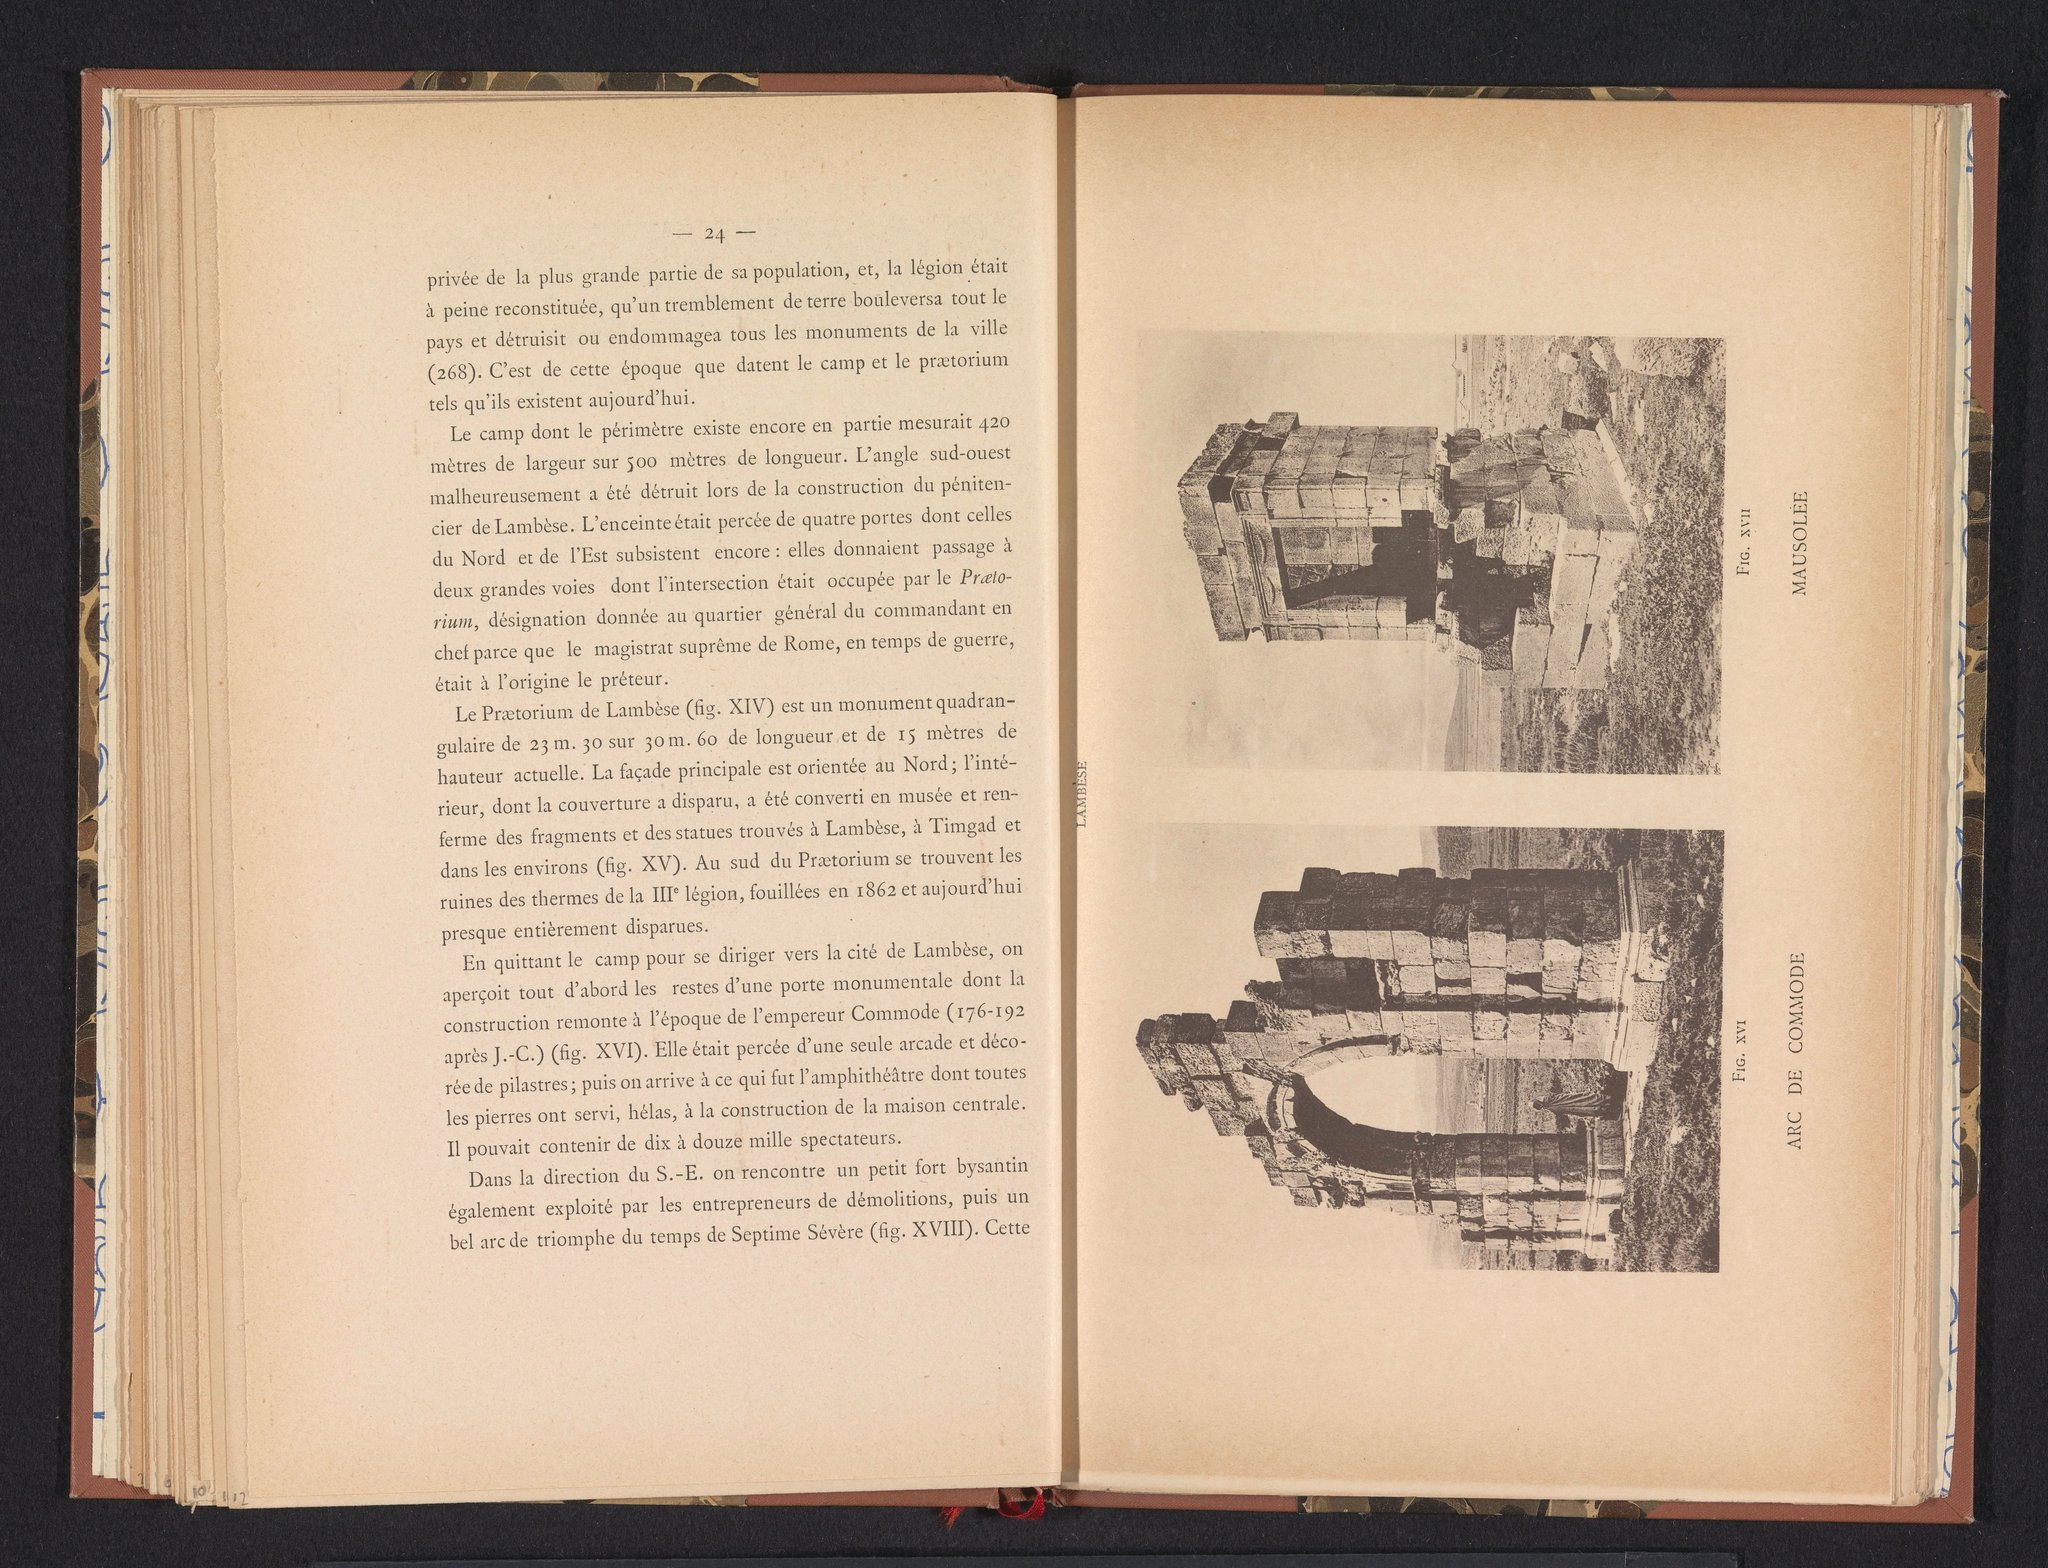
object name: page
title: Romeinse boog en een mausoleum bij Lambaesis in Algerije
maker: Anonymous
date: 1884-1894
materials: paper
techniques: photograph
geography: france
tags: mausoleum, gate, entrance, ruin of a dwelling, house, castle, etc.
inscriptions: number: ‘Fig. XVI Fig. XVII’